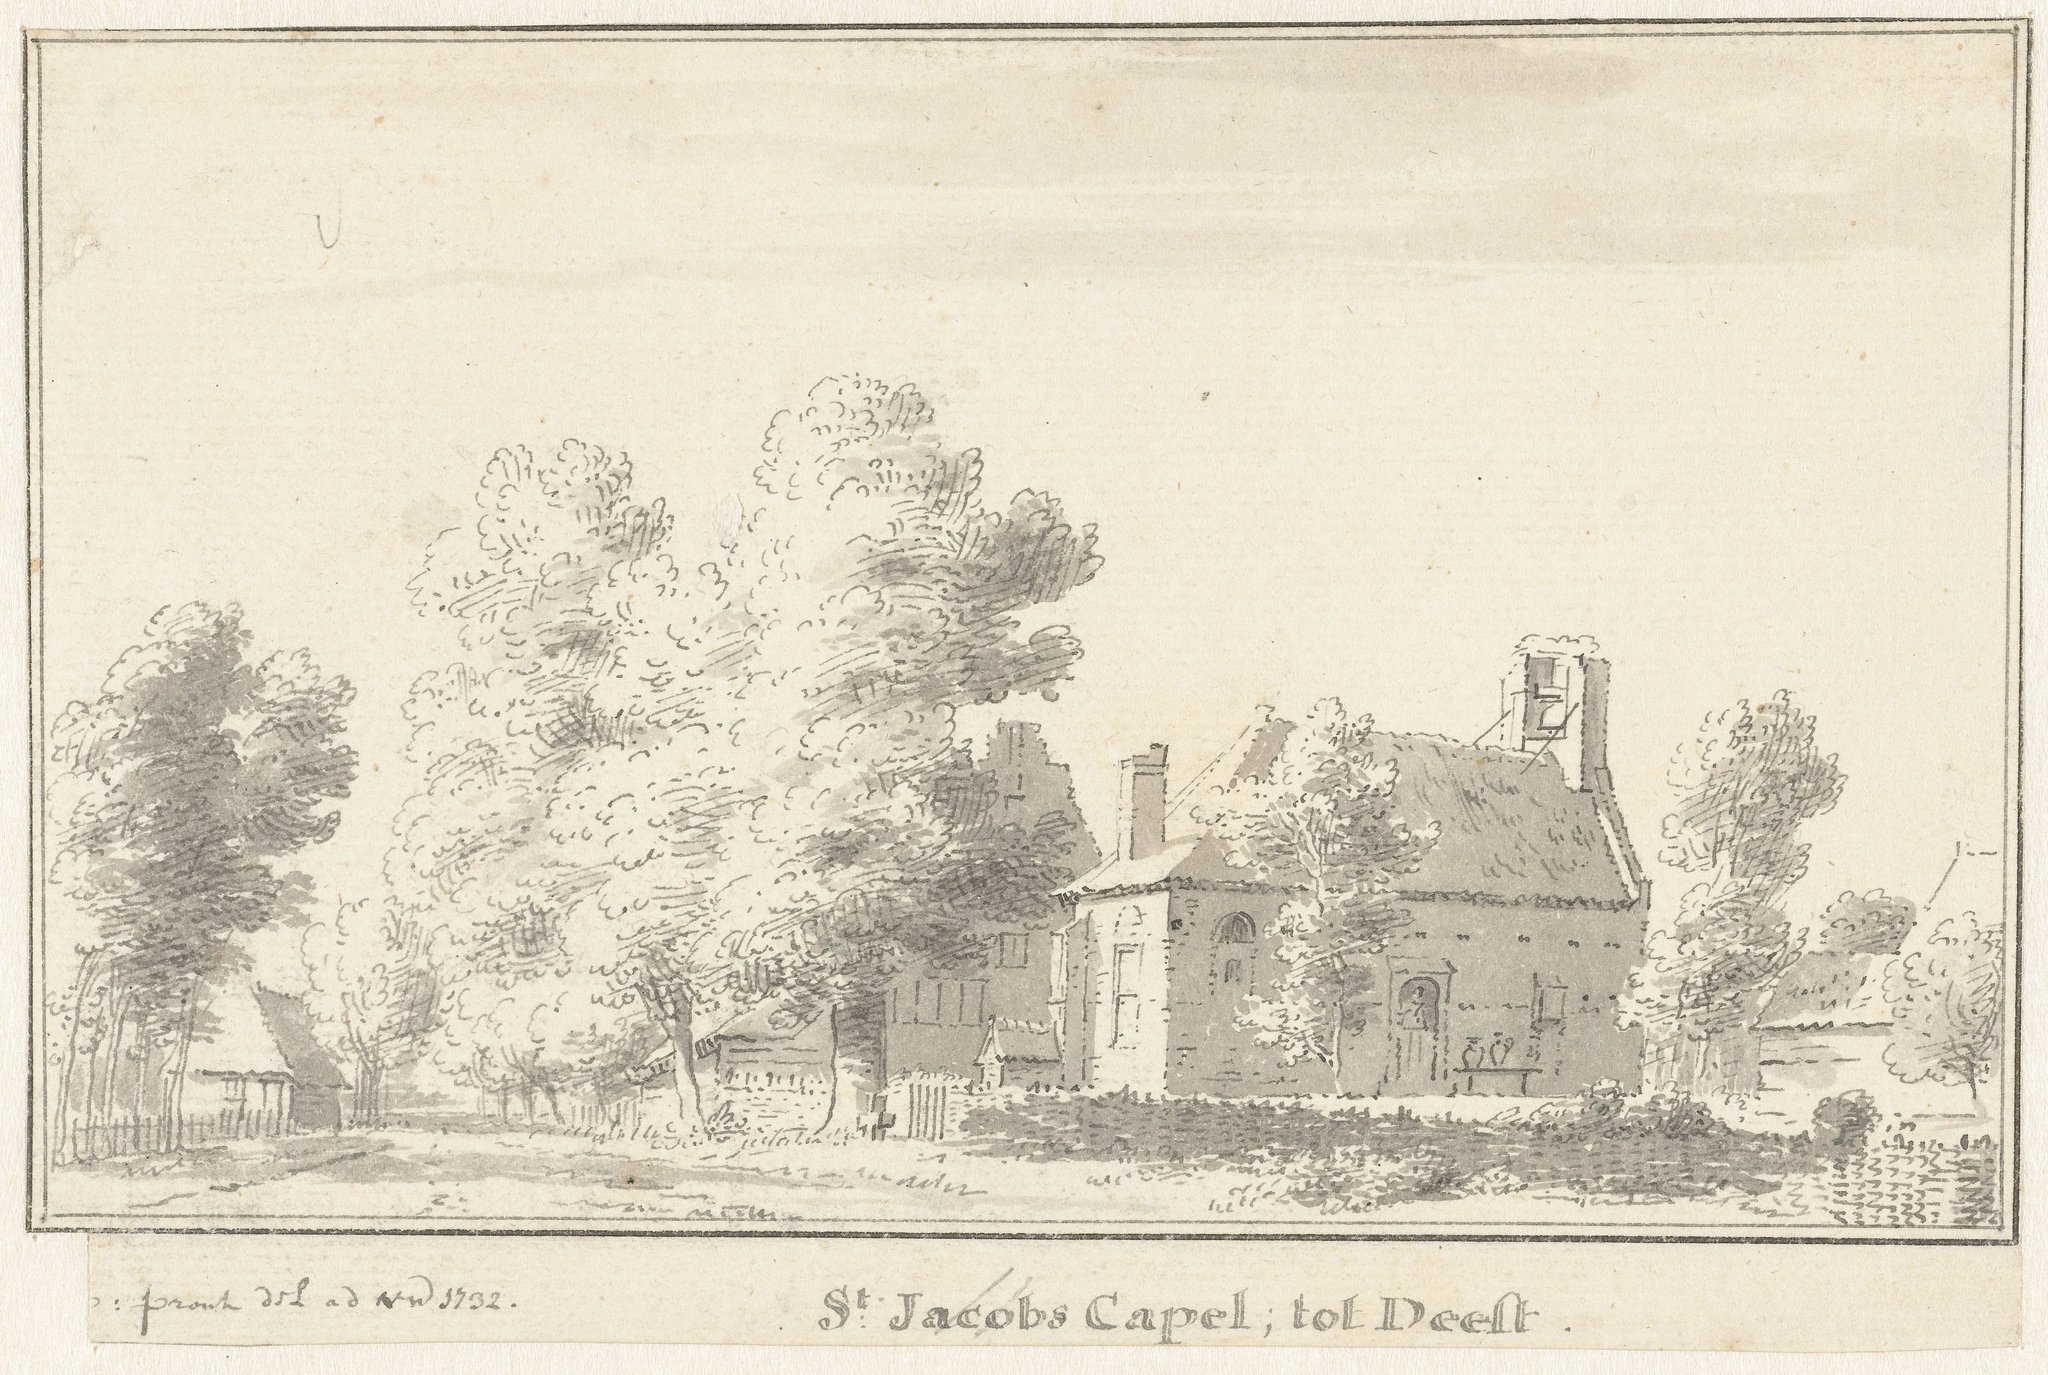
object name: drawing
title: De St.-Jacobskapel te Deest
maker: cornelis pronk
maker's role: draughtsman, painter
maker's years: 1691-1759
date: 1732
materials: ink, paper, pencil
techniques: brush, pen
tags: church (exterior)